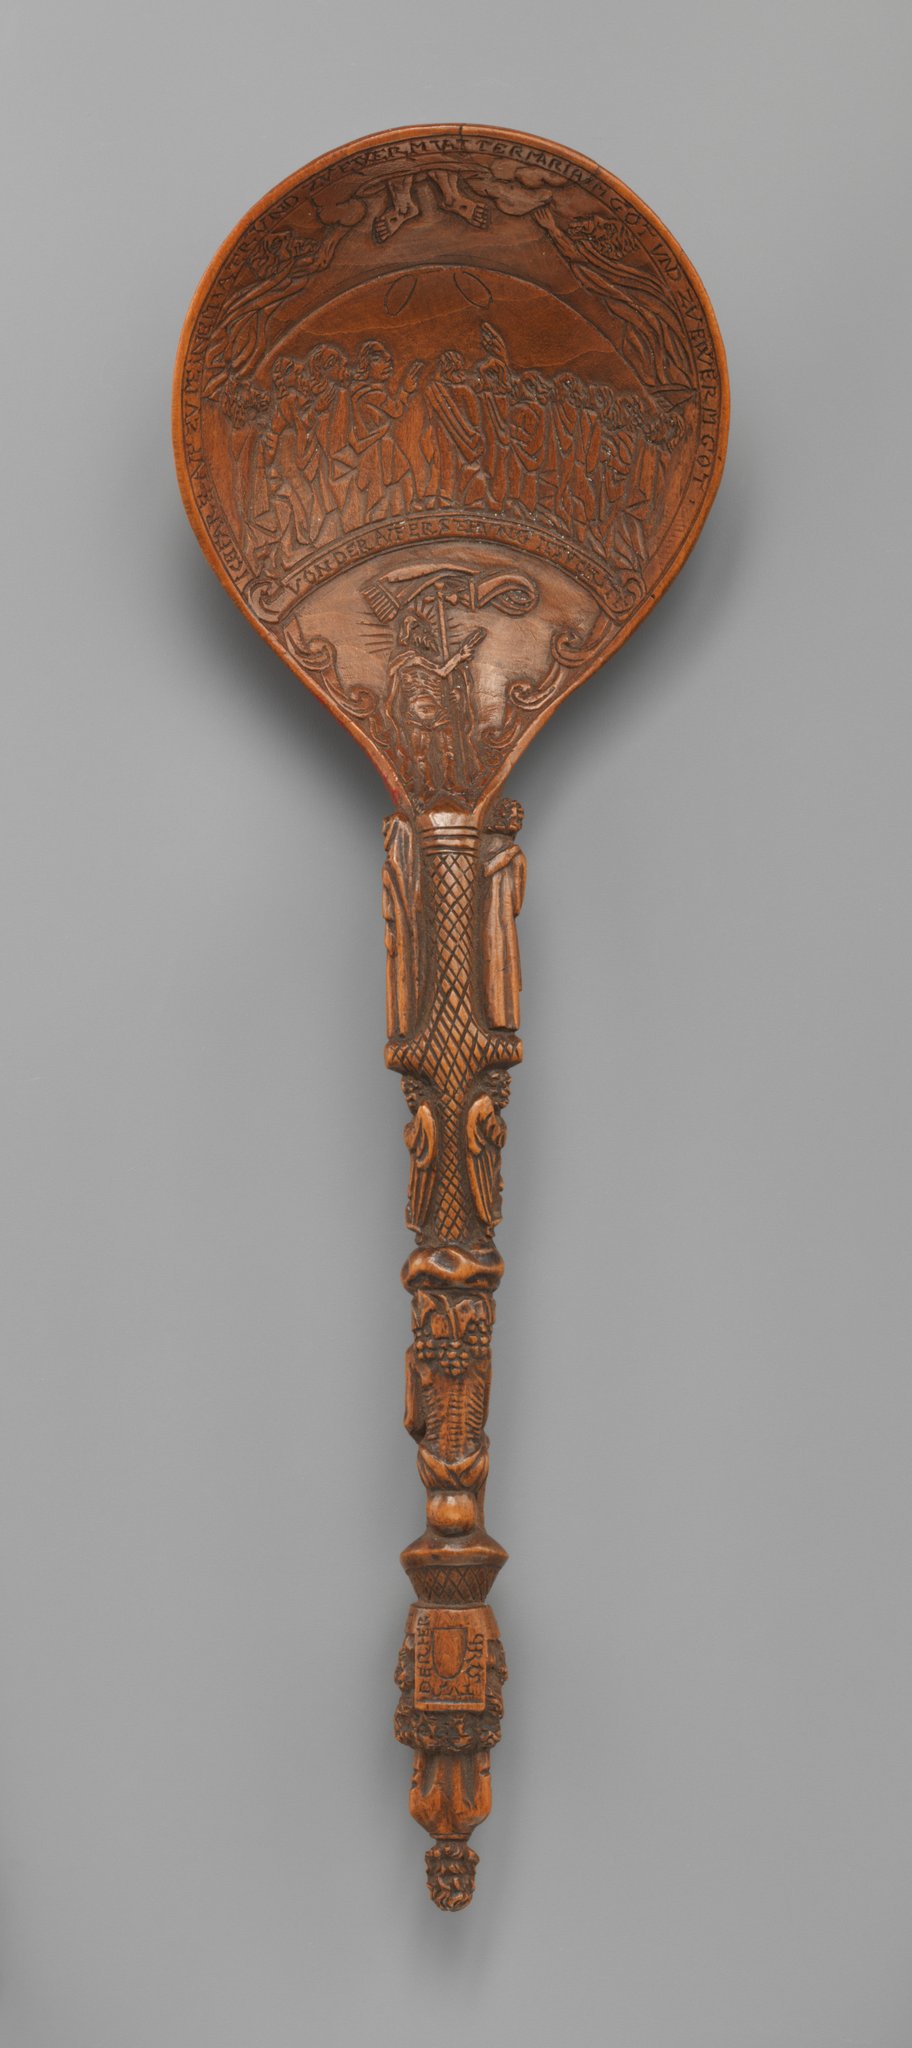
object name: spoon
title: Scenes of the Passion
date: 1681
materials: wood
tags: christ,crucifixion